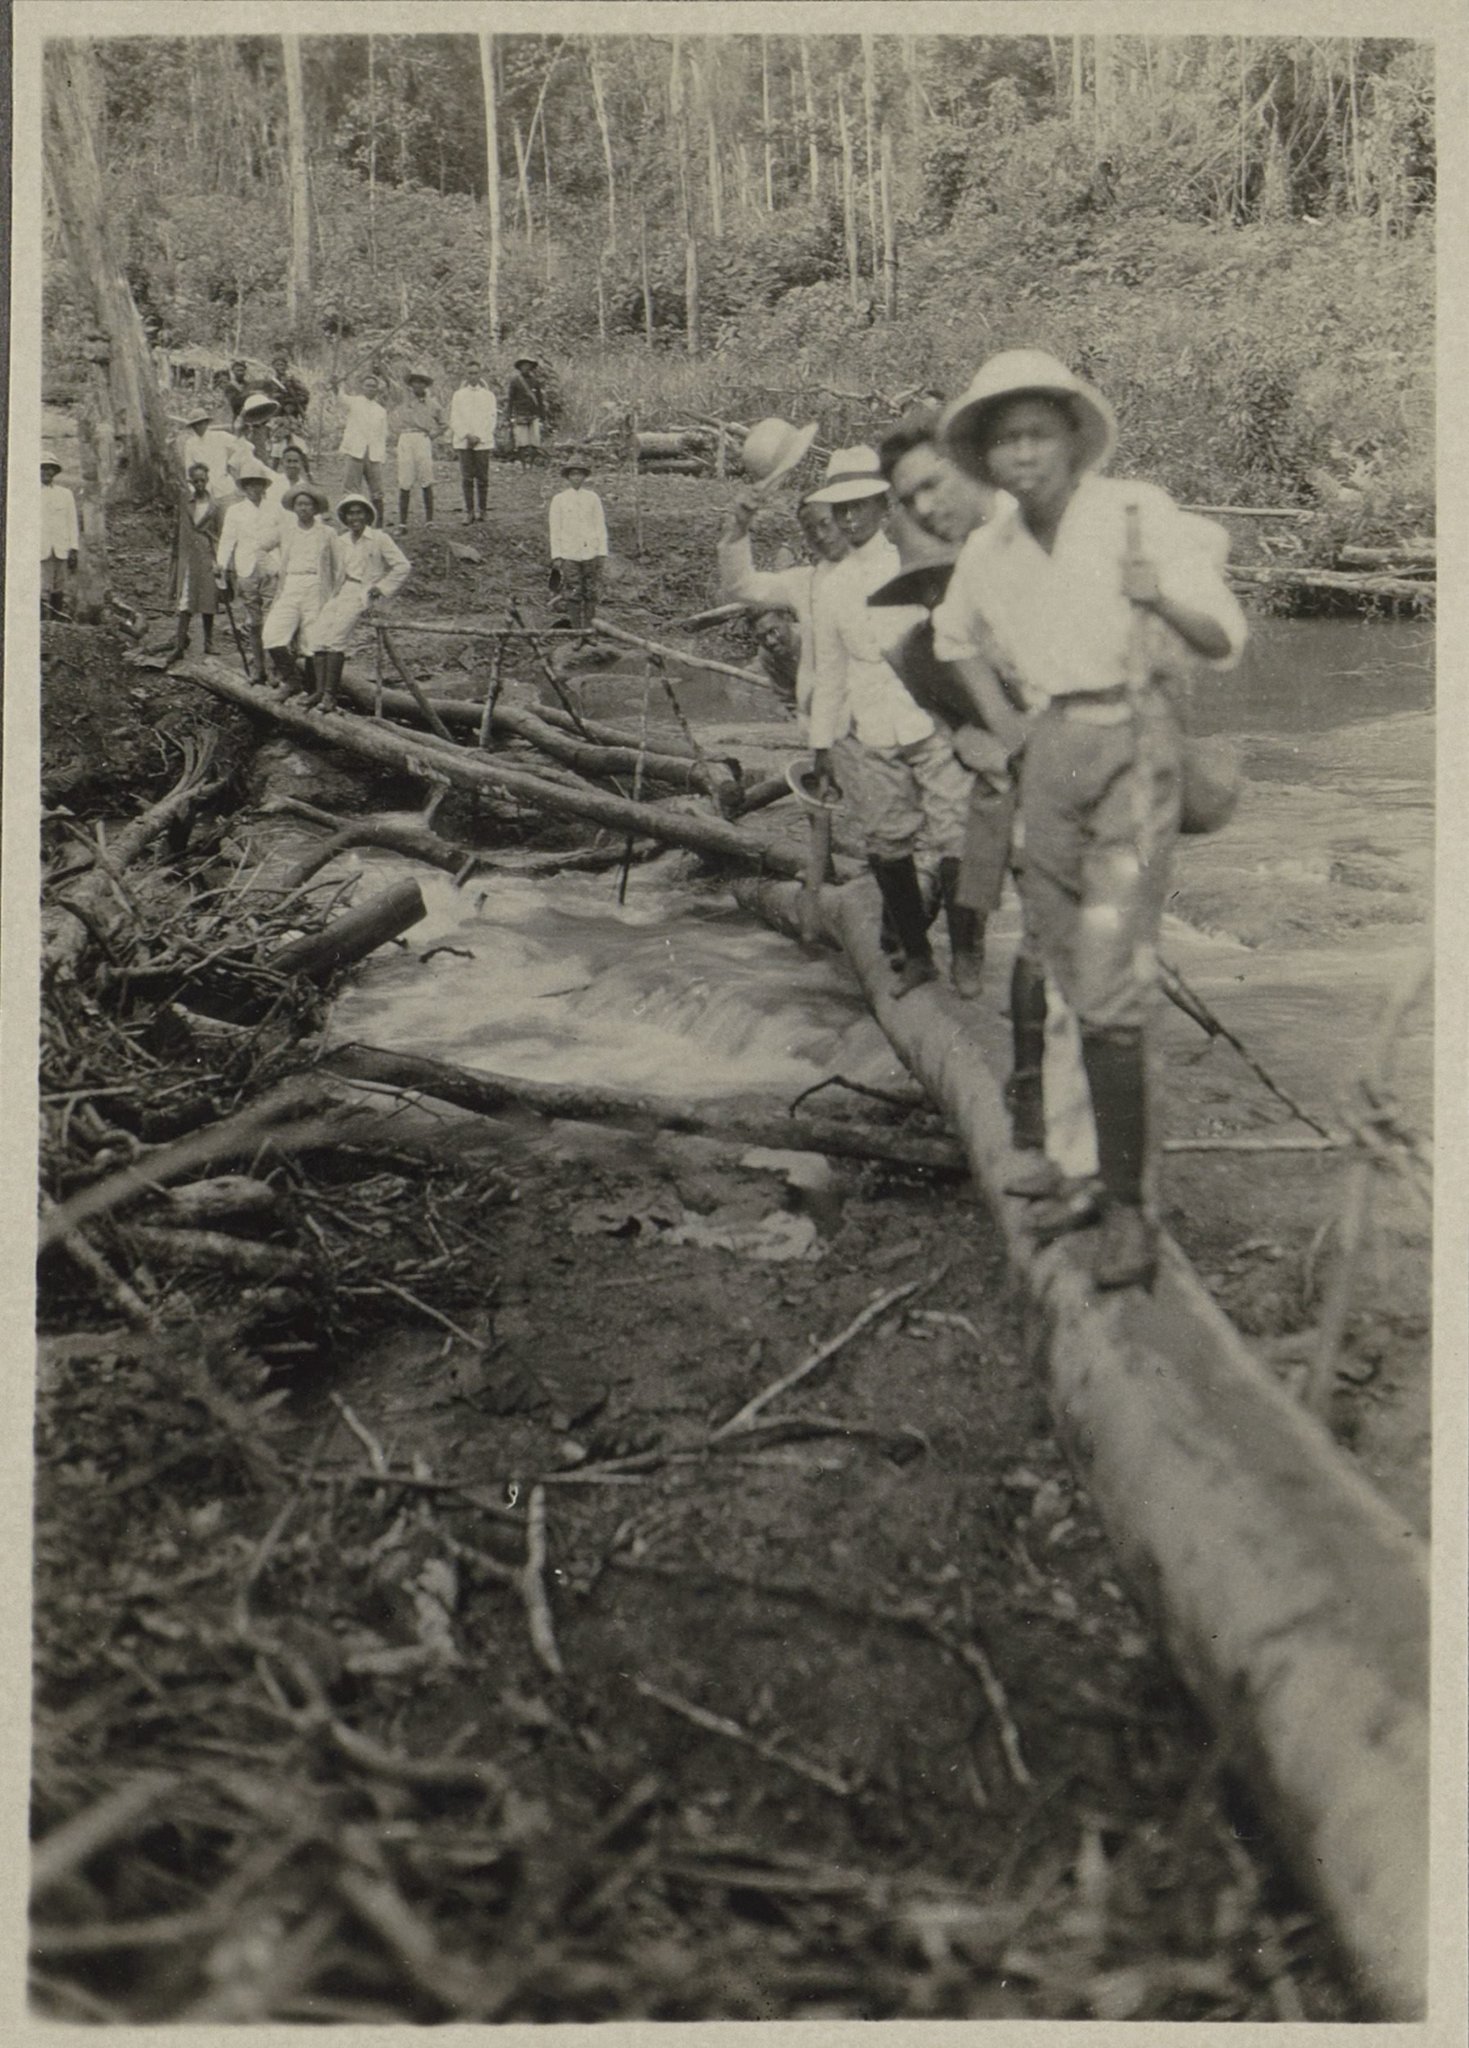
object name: photograph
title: Een wild stroompje op den weg naar de pas ontgonnen terreinen.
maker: Anonymous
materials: photographic support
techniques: gelatin silver print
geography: dutch east indies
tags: official; civil servant; functionary (in general), bridge, dutch east indies, the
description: Onderdeel van Fotoalbum aangeboden aan de resident der Lampongse districten F.J. Junius door studerende ambtenaren van de bestuursschool te Batavia.